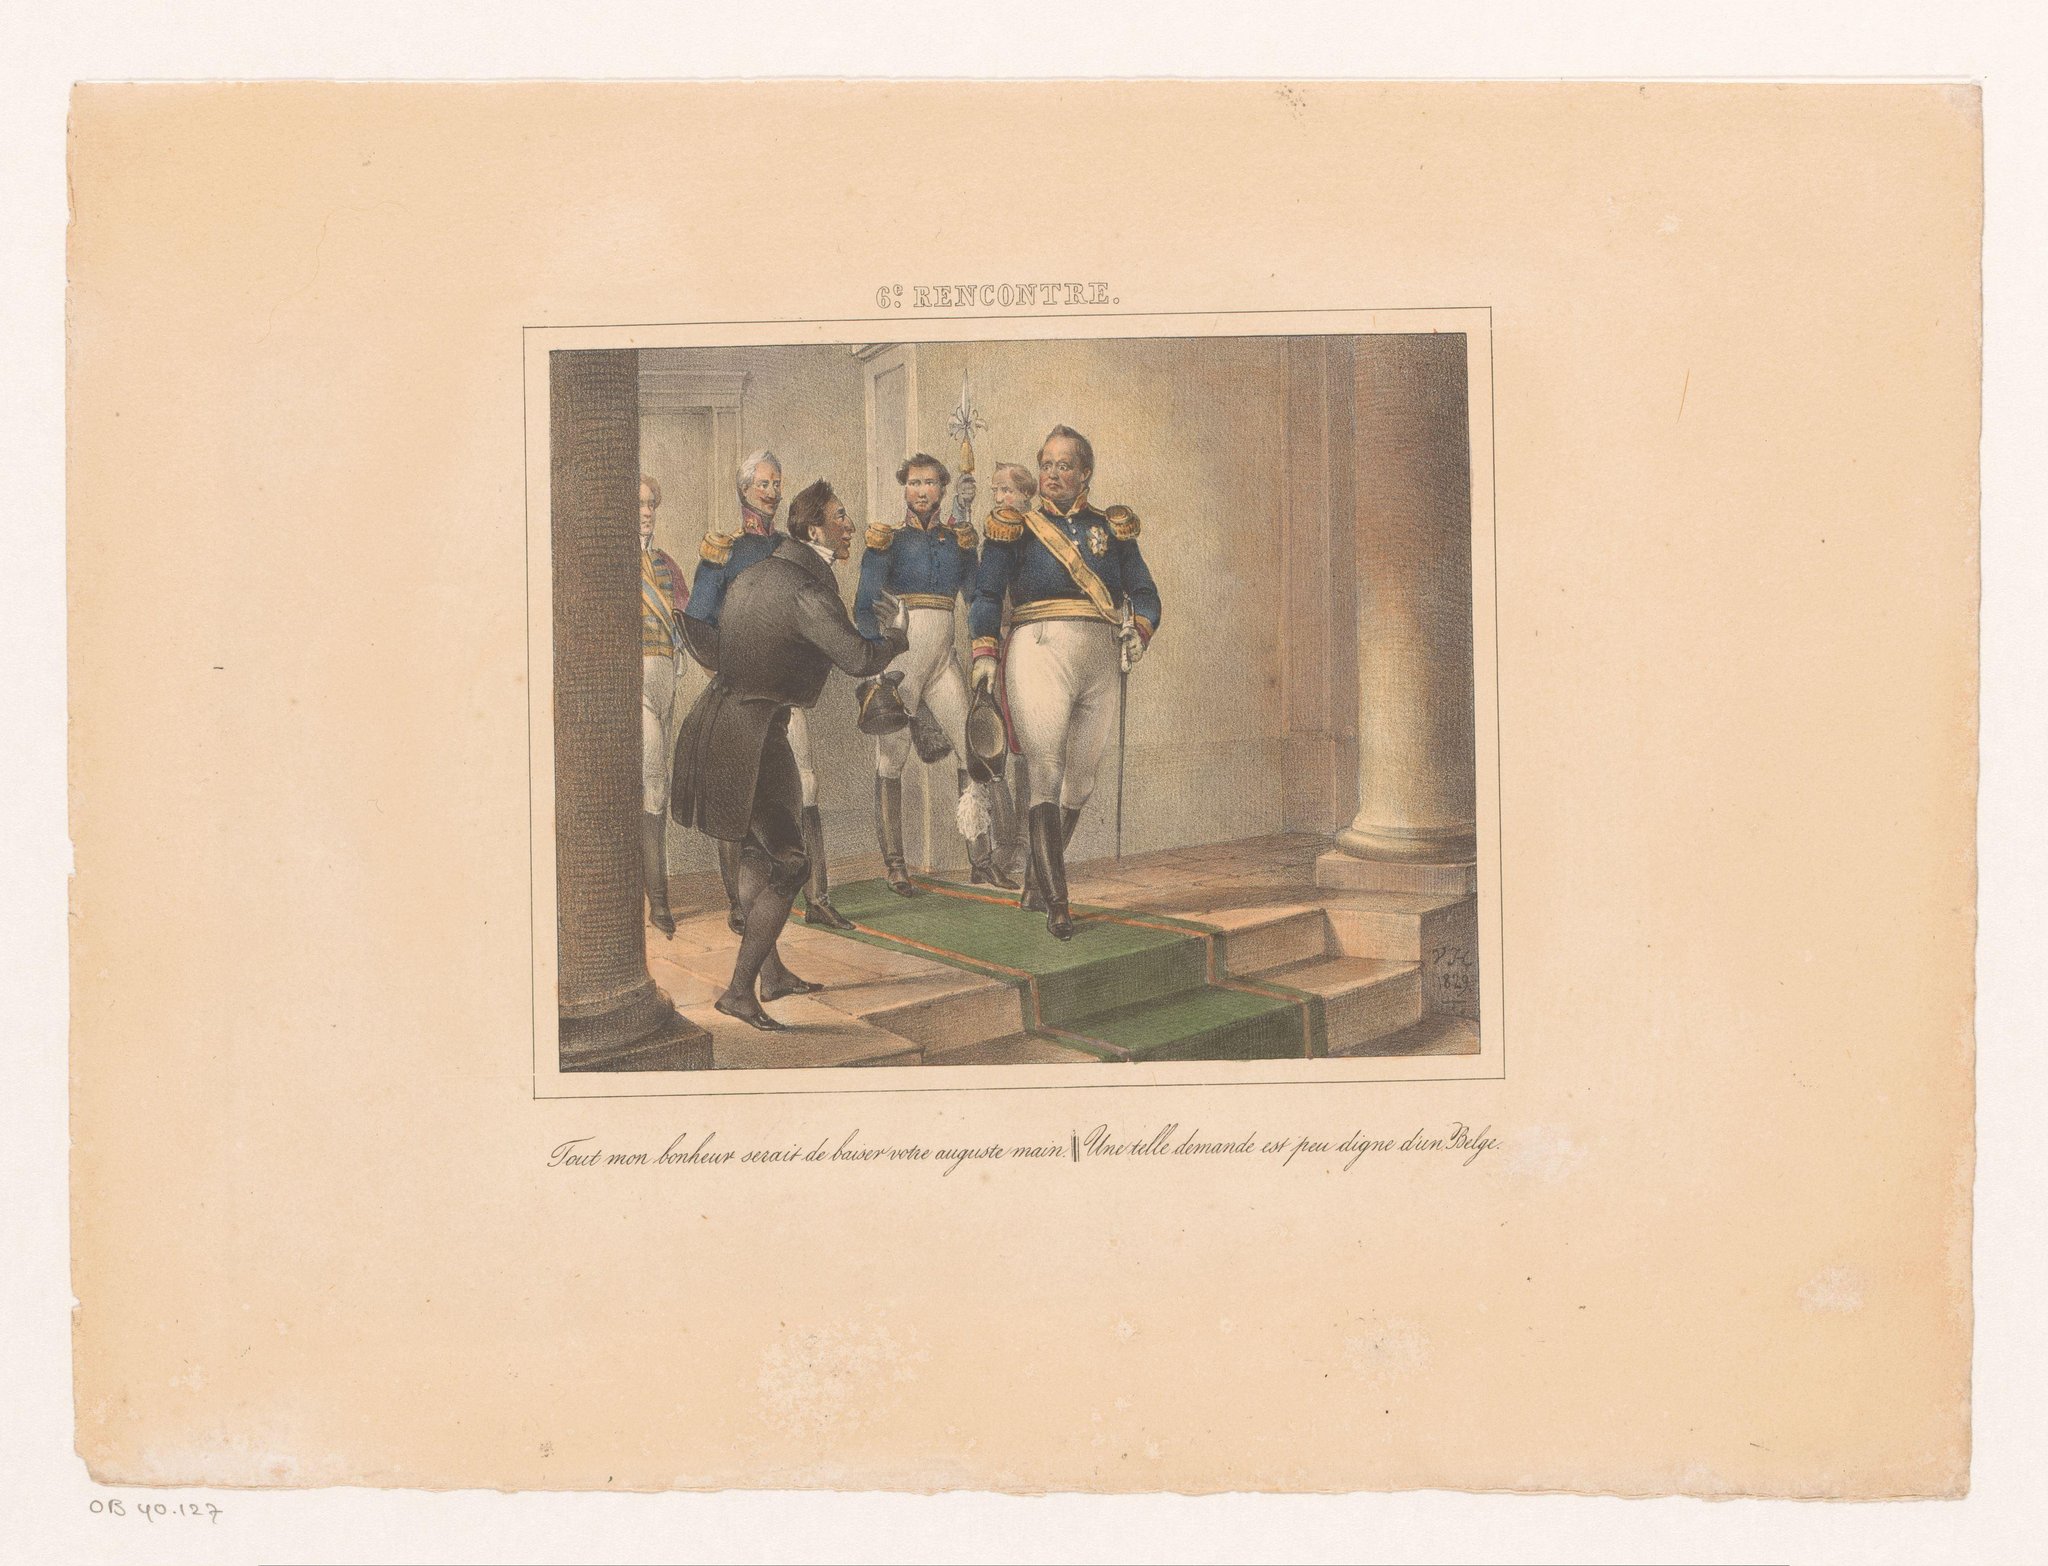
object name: print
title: 6e Rencontre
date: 1829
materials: paper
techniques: hand coloring, lithograph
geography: brussels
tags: the hague, berlin, william i of the netherlands, ruler in informal contact with his subjects, flattery; 'adulatione' (ripa) (+ situation or event (especially in genre-painting) with symbolical connotation)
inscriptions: collector's mark: Lugt 2228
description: De koning bestraft een vleier. Met tweeregelig onderschrift. Onderdeel van de serie van 24 platen met ontmoetingen met koning Willem I, verschenen onder de titel 'Les rencontres' in 1829-1830.